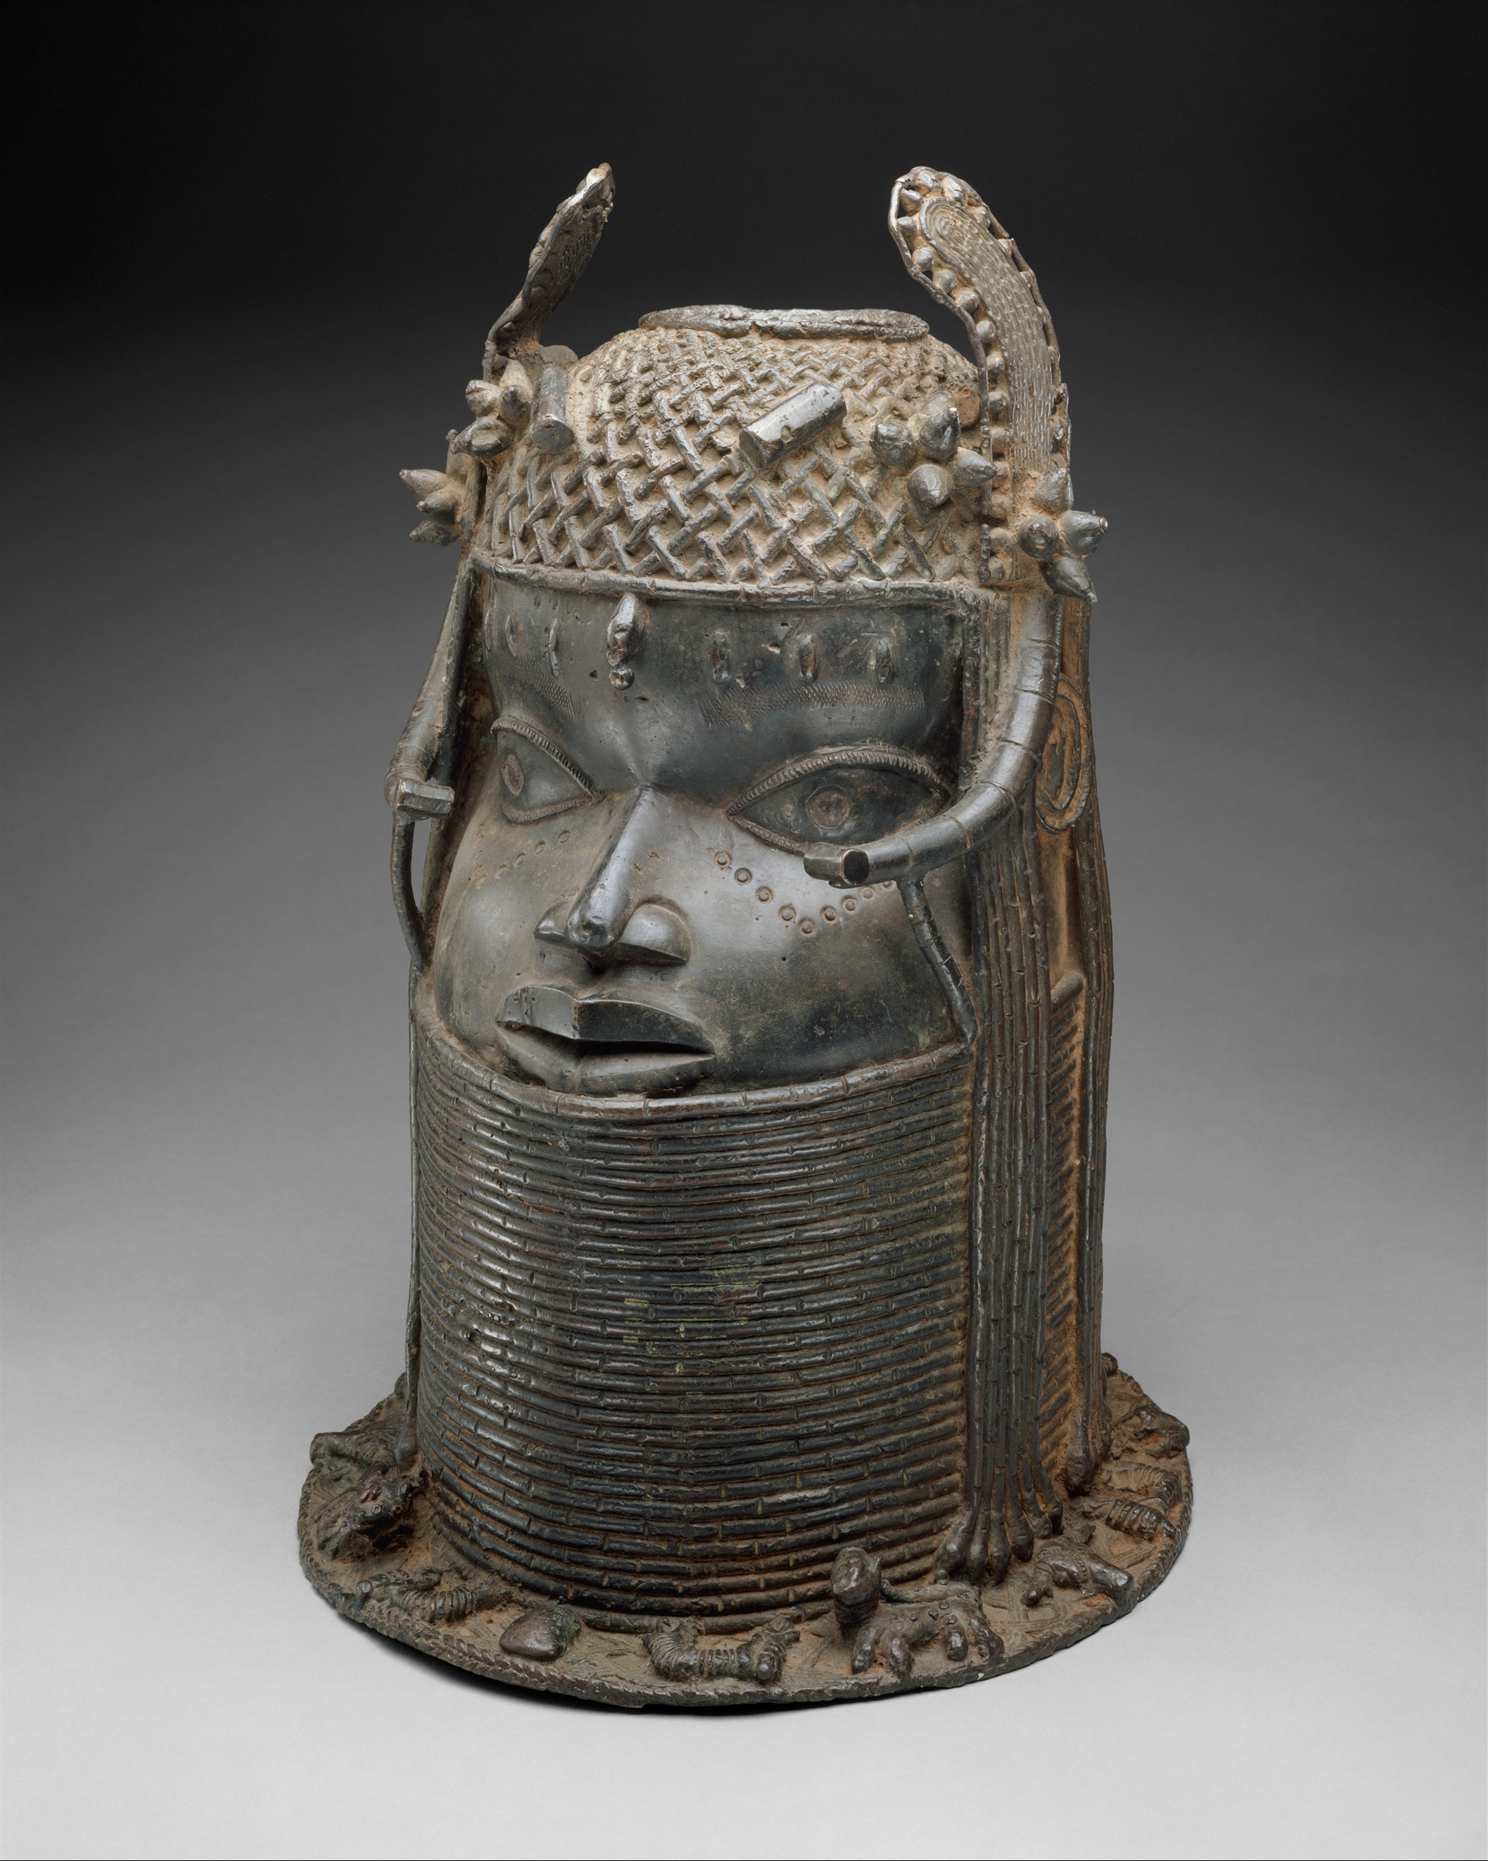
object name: head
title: Head of an Oba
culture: edo period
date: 1801-1900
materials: brass, iron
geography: nigeria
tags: heads